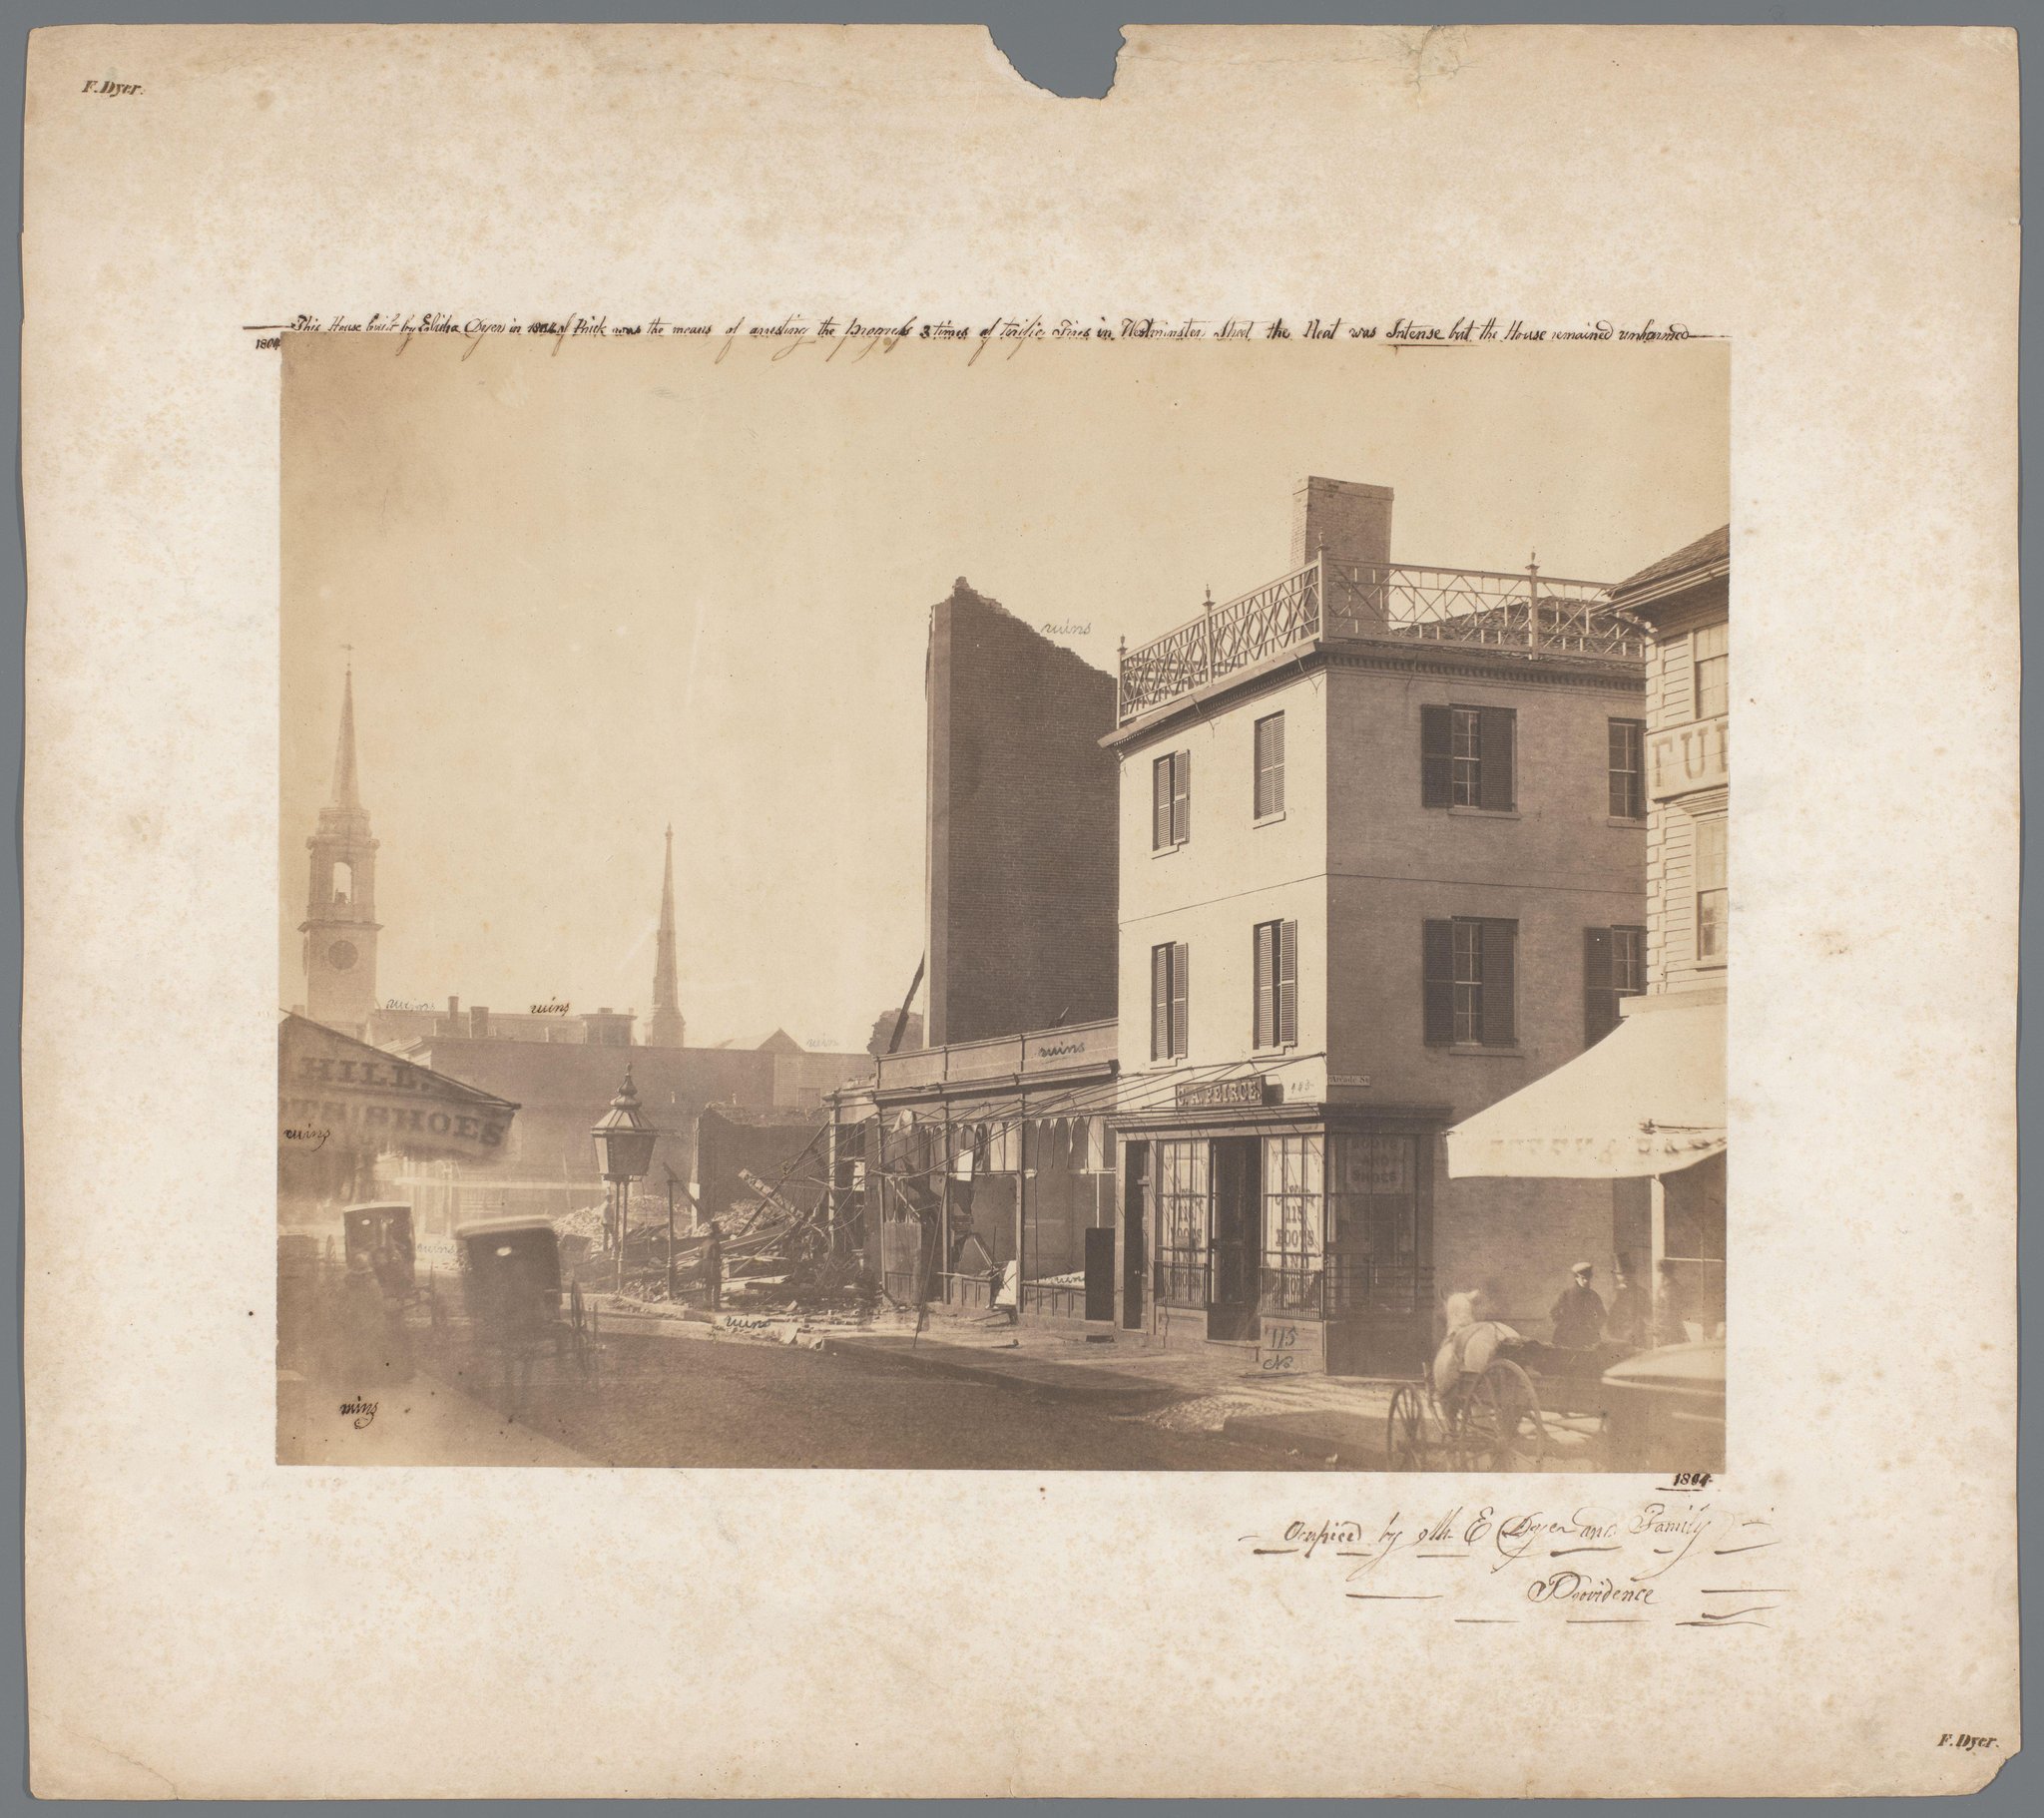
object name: photograph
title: Westminster Street, Providence, R.I.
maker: francis hacker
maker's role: fotograaf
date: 1855-1865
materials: paper, photographic support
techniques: salted paper print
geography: providence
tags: providence